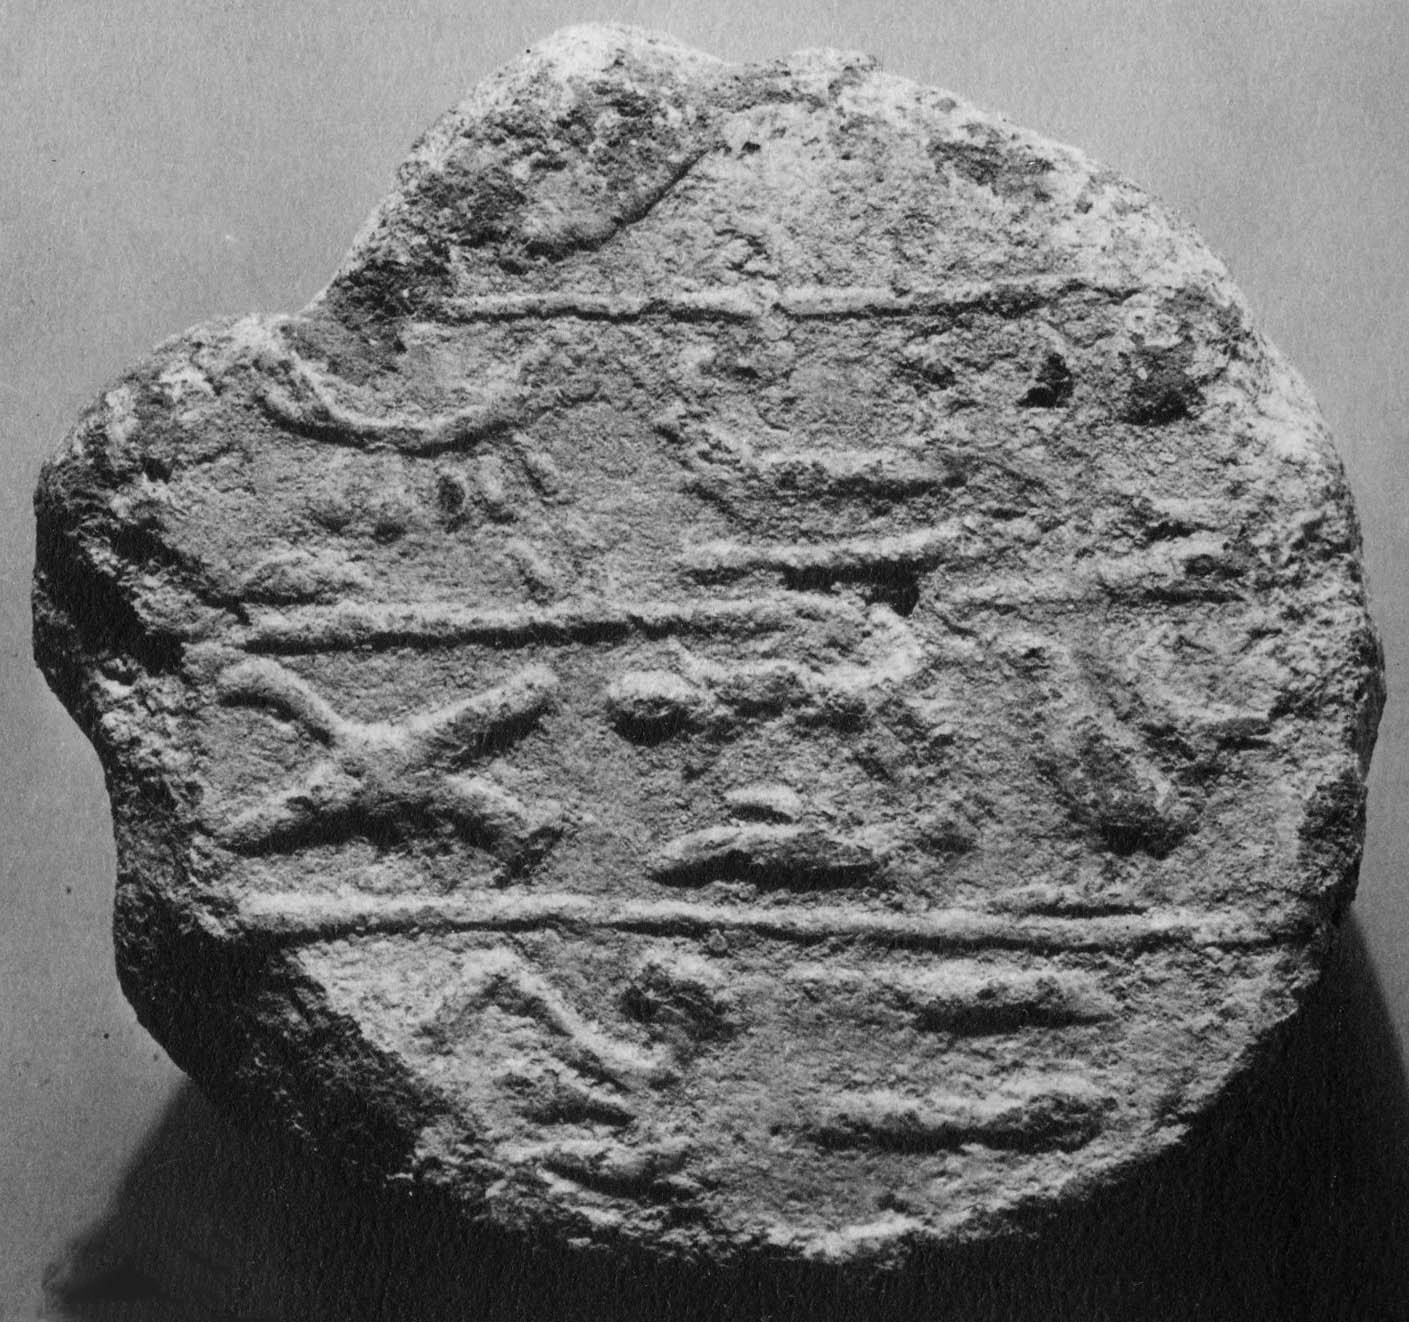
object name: cone, pashed, circular impression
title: Funerary Cone of Pashed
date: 1550-1295 BCE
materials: pottery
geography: egypt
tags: hieroglyphs